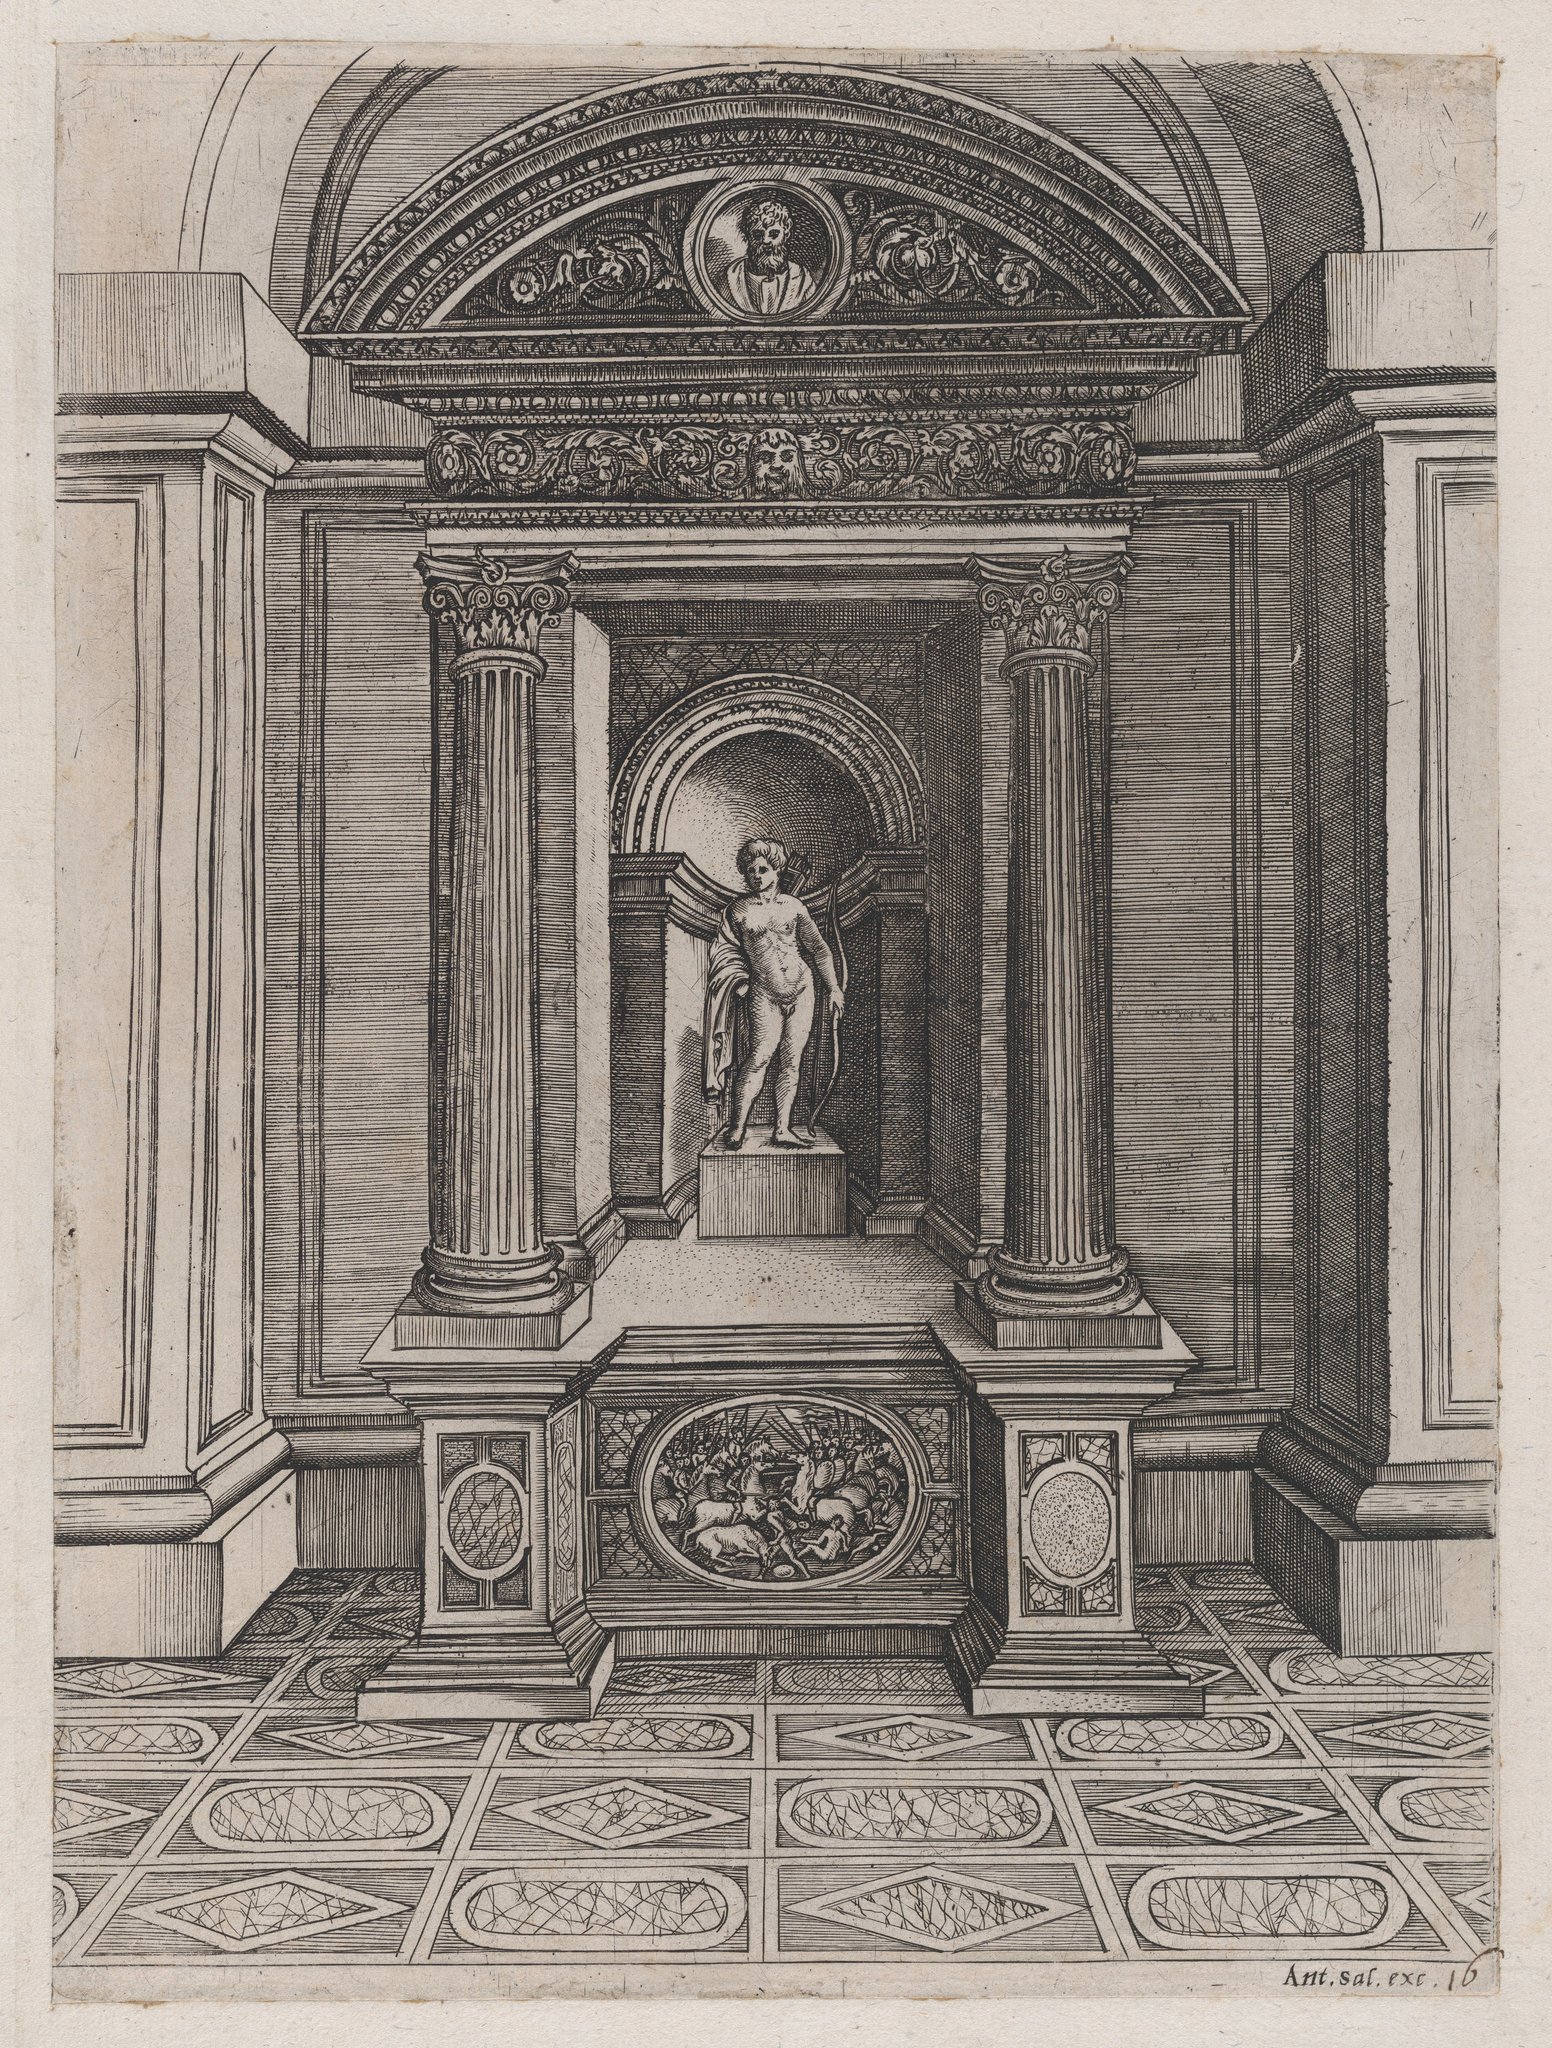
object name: print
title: The Altar of Eros, from "Speculum Romanae Magnificentiae"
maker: agostino veneziano (agostino dei musi)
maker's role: artist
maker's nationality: italian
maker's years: 1490-1536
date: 1514-1536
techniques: engraving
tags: altars,eros,rome